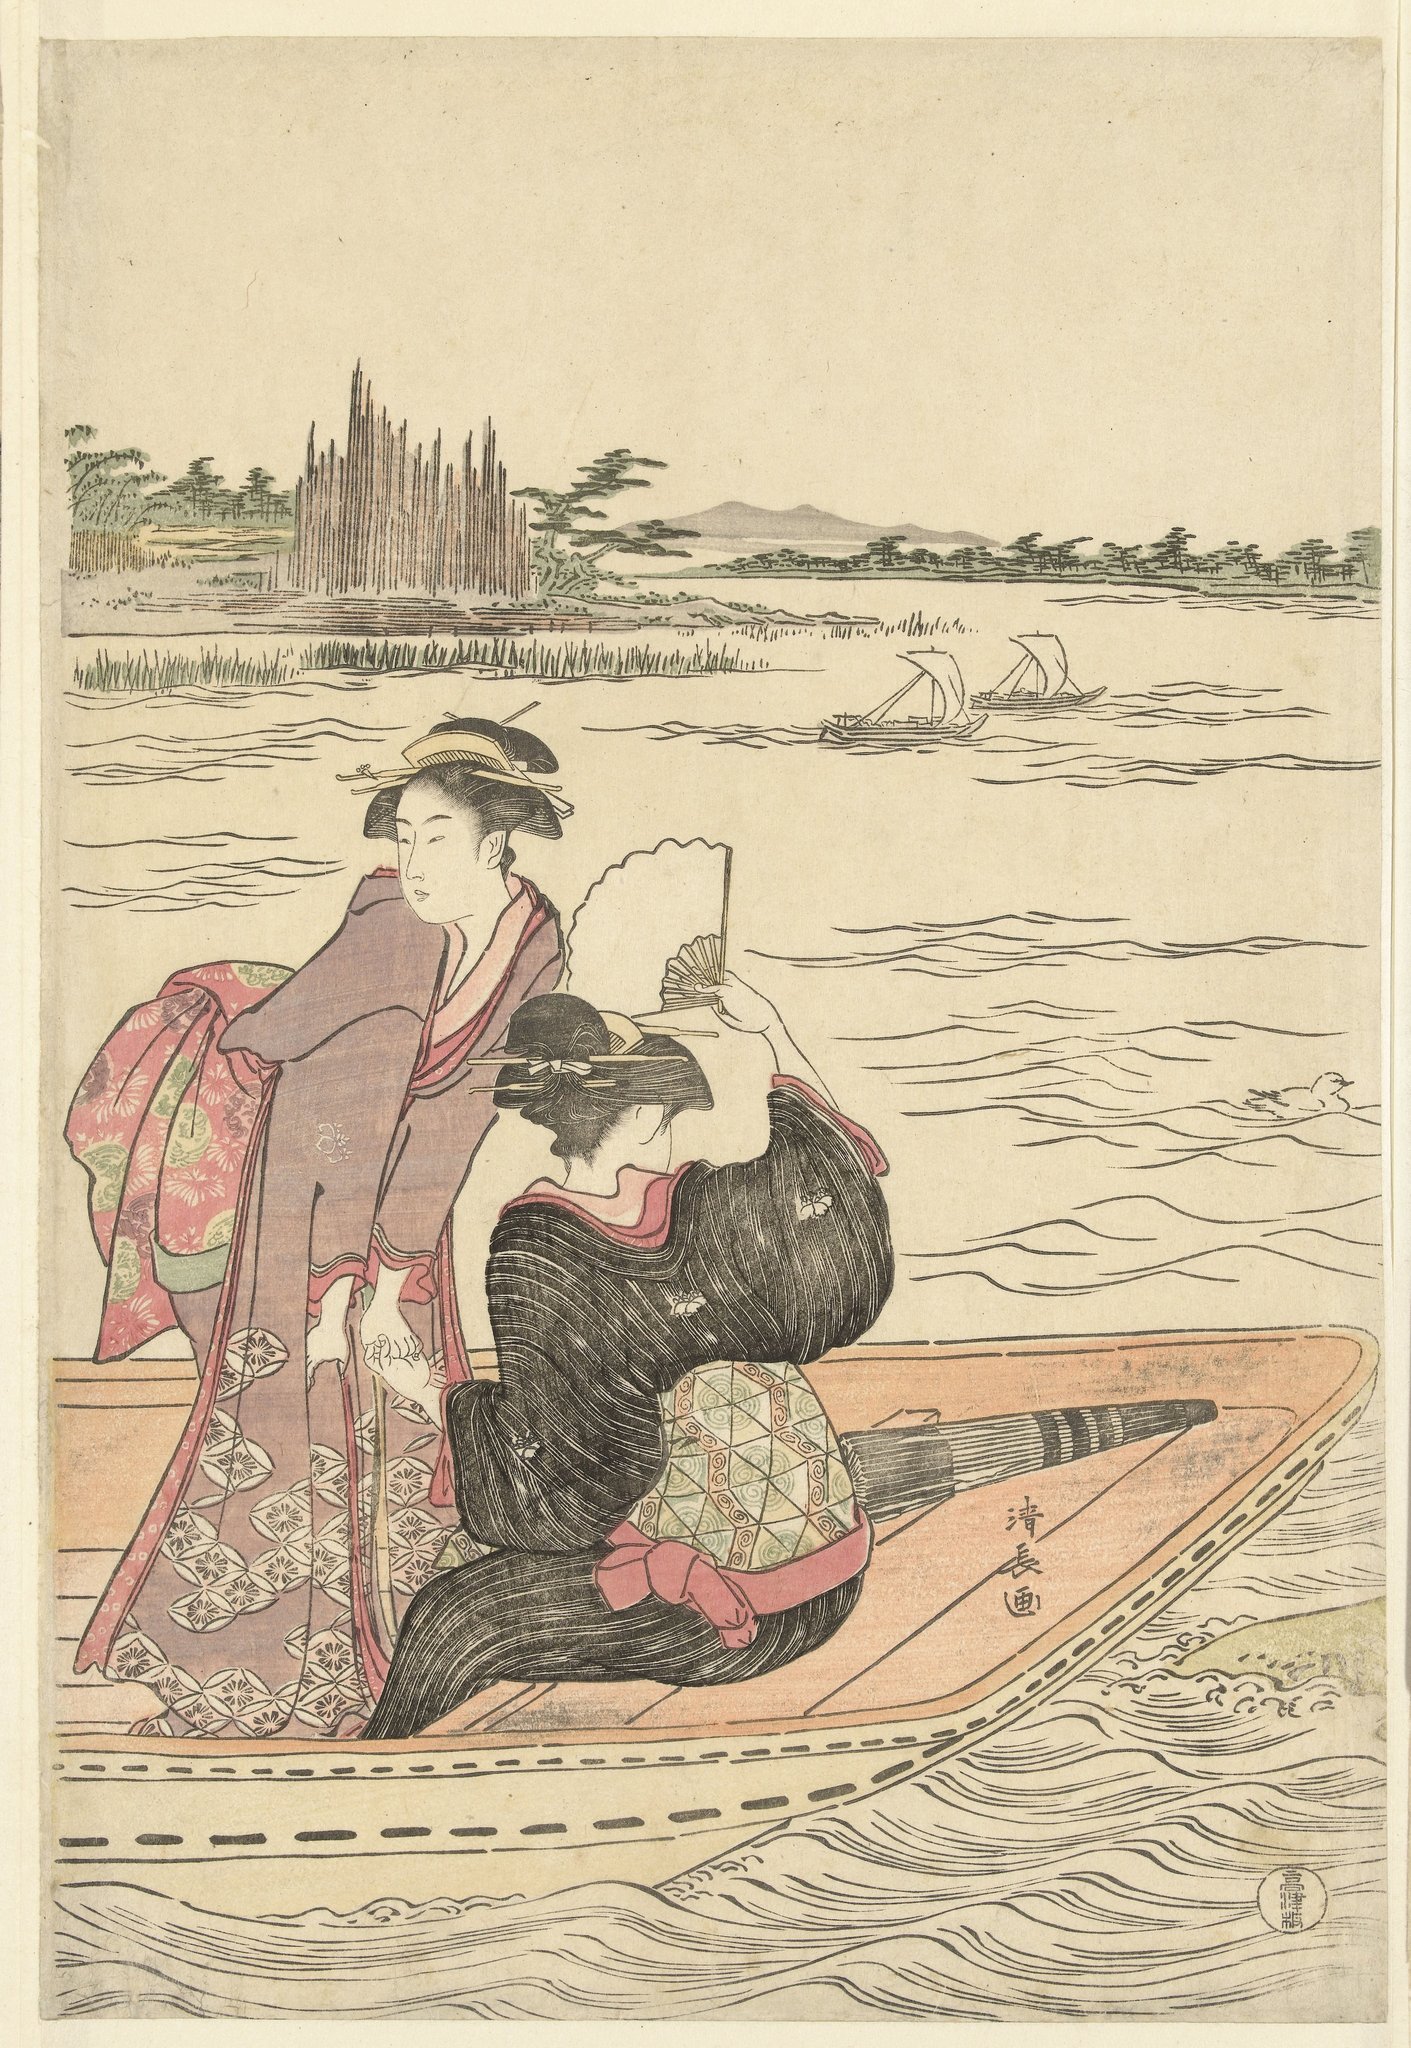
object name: print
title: Veerboot op de rivier de Sumida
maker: torii kiyonaga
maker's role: draughtsman, print maker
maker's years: 1752-1815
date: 1785-1789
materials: paper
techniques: woodcut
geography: japan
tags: sailing-ship, sailing-boat, rowing-boat, canoe, etc., adult woman (+ two persons)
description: Twee vrouwen in veerboot; op de achtergrond twee zeilschepen en een houtwerf